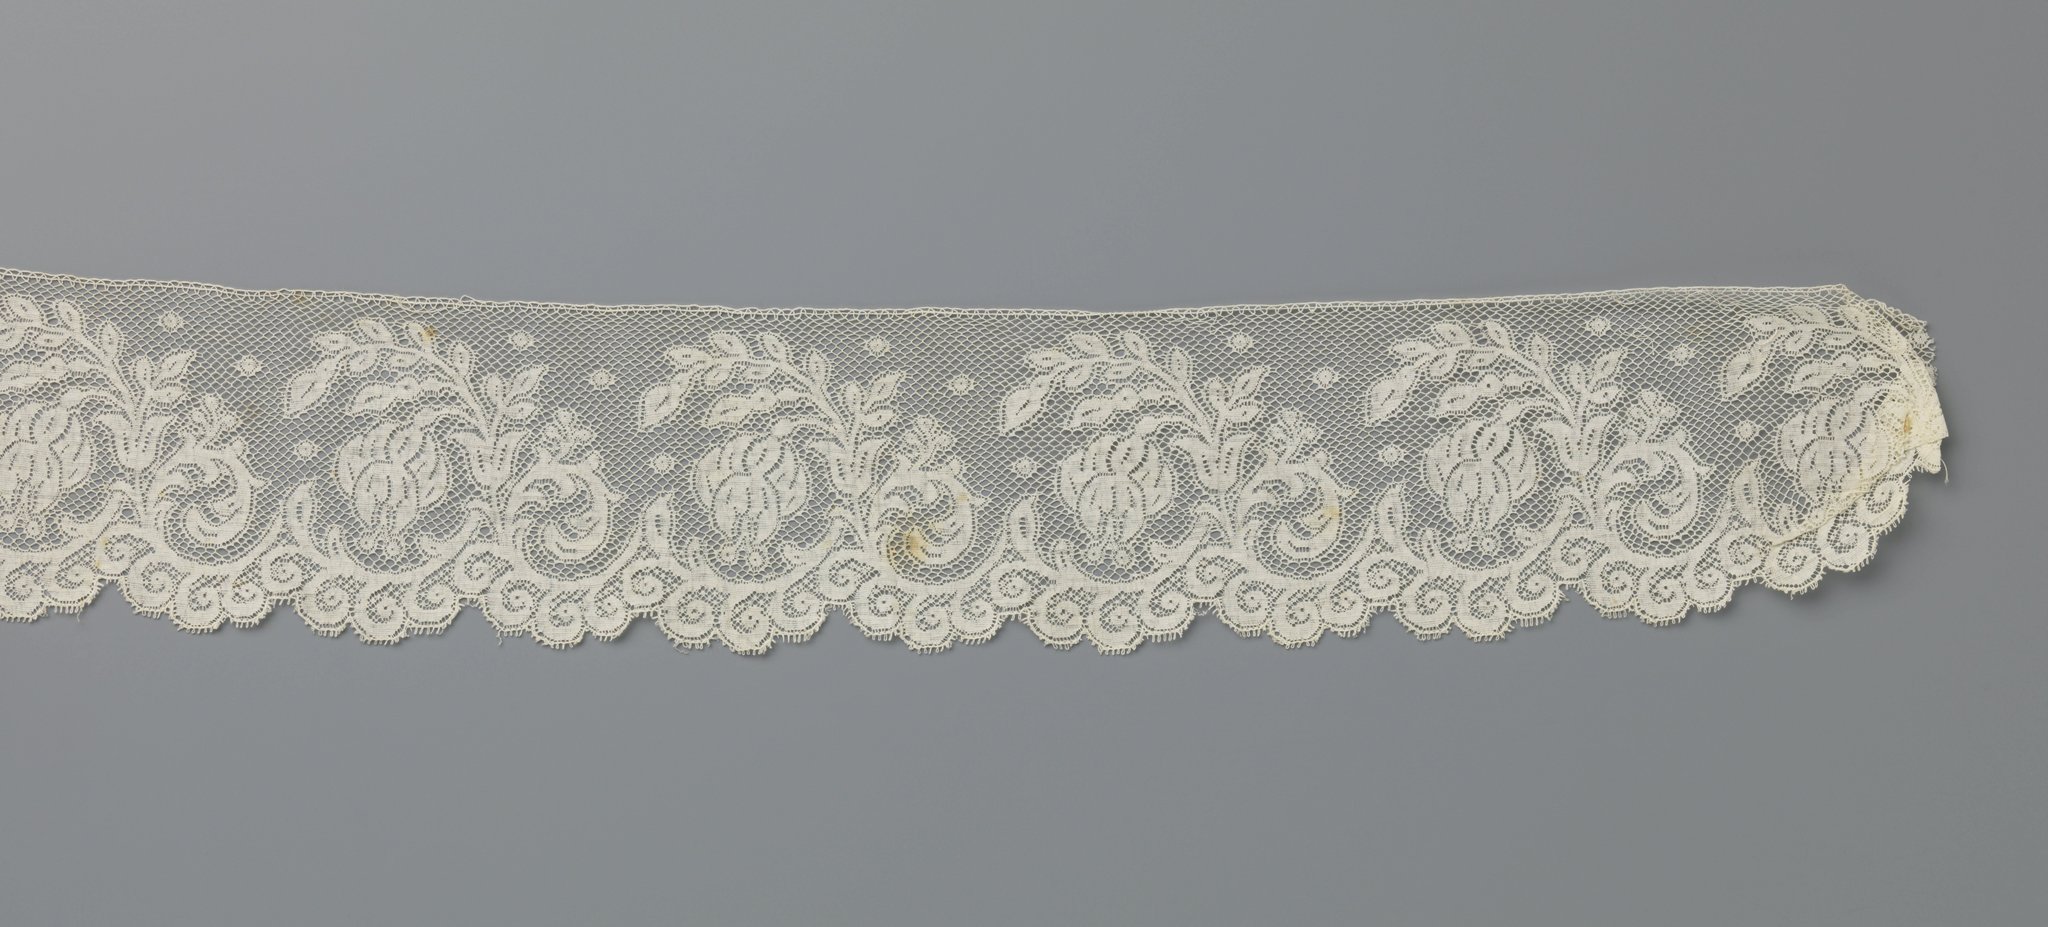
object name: strip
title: Strook machinale kant met fuchsiabloem in c-vormige tak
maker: Anonymous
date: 1875-1899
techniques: lace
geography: western europe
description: Strook naturelkleurige machinale kant: machinale Valenciennes-kant. Het zich herhalende patroon bestaat uit een c-vormige tak, waarin een fuchsia-achtige bloem hangt. Direct tegen de tak aan ontspringt vanuit de onderzijde een kleinere, gespiegelde c-voluut. De schulpen langs de onderzijde bestaan steeds uit drie kleine schulpjes, die ontstaan door c-voluutjes die aan de onderkant van het patroon hangen. De motieven zijn met elkaar verbonden door een ruitvormige traliegrond. In de motieven zijn uitsparingen gemaakt en rom de motieven opengewerkte randjes. Tussen de c-voluutjes aan de onderkant van het patroon is als siergrond een fijne machinale sneeuwvlokkengrond toegepast.